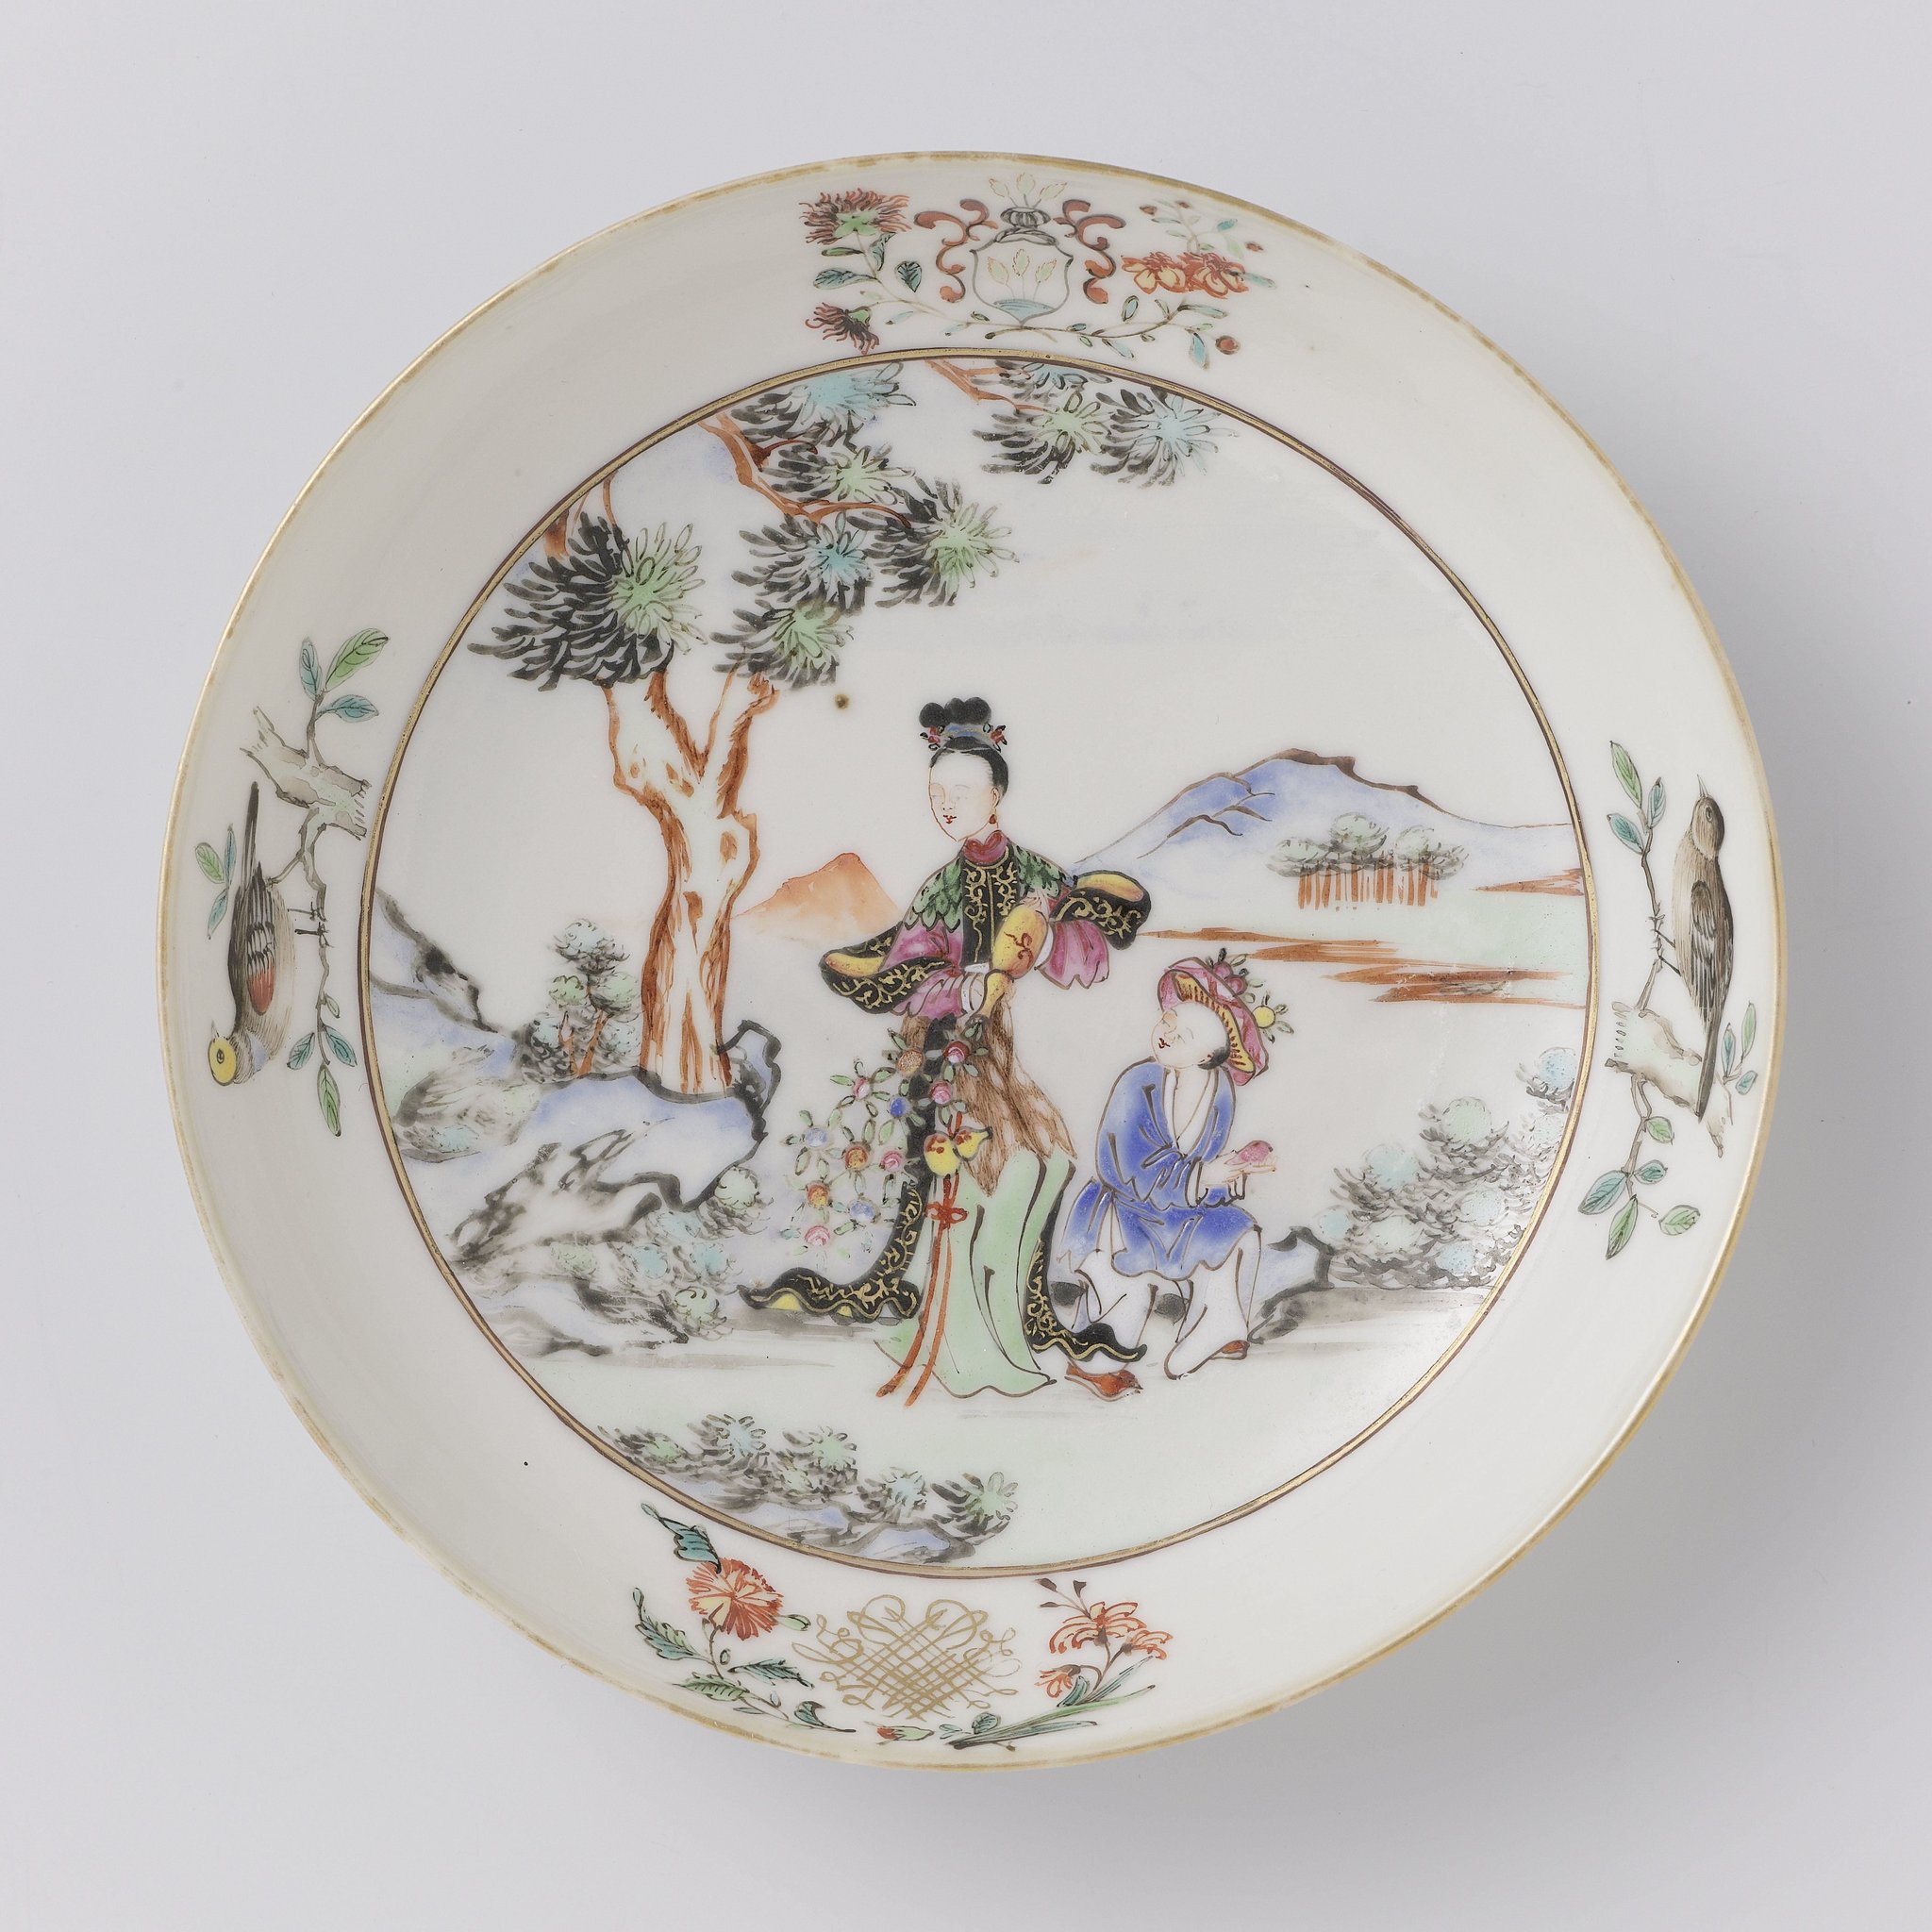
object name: platter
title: Dish depicting Ma Gu and a European coat of arms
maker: Anonymous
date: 1750-1774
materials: glaze, gold, paint, porcelain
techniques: firing, gilding, turning, vitrification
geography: china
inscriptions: label: ‘Van Sorgen Metelerkamp?’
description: Would the European commissioner of this dish have understood this wish of good fortune? The woman is the immortal Ma Gu, the goddess of longevity. Dressed in a deerskin, she holds a vase upside down. The yellow gourd on her belt contains wine from lingzhi, the mushroom of immortality. Her characteristic long, birdlike fingernails are not depicted here.